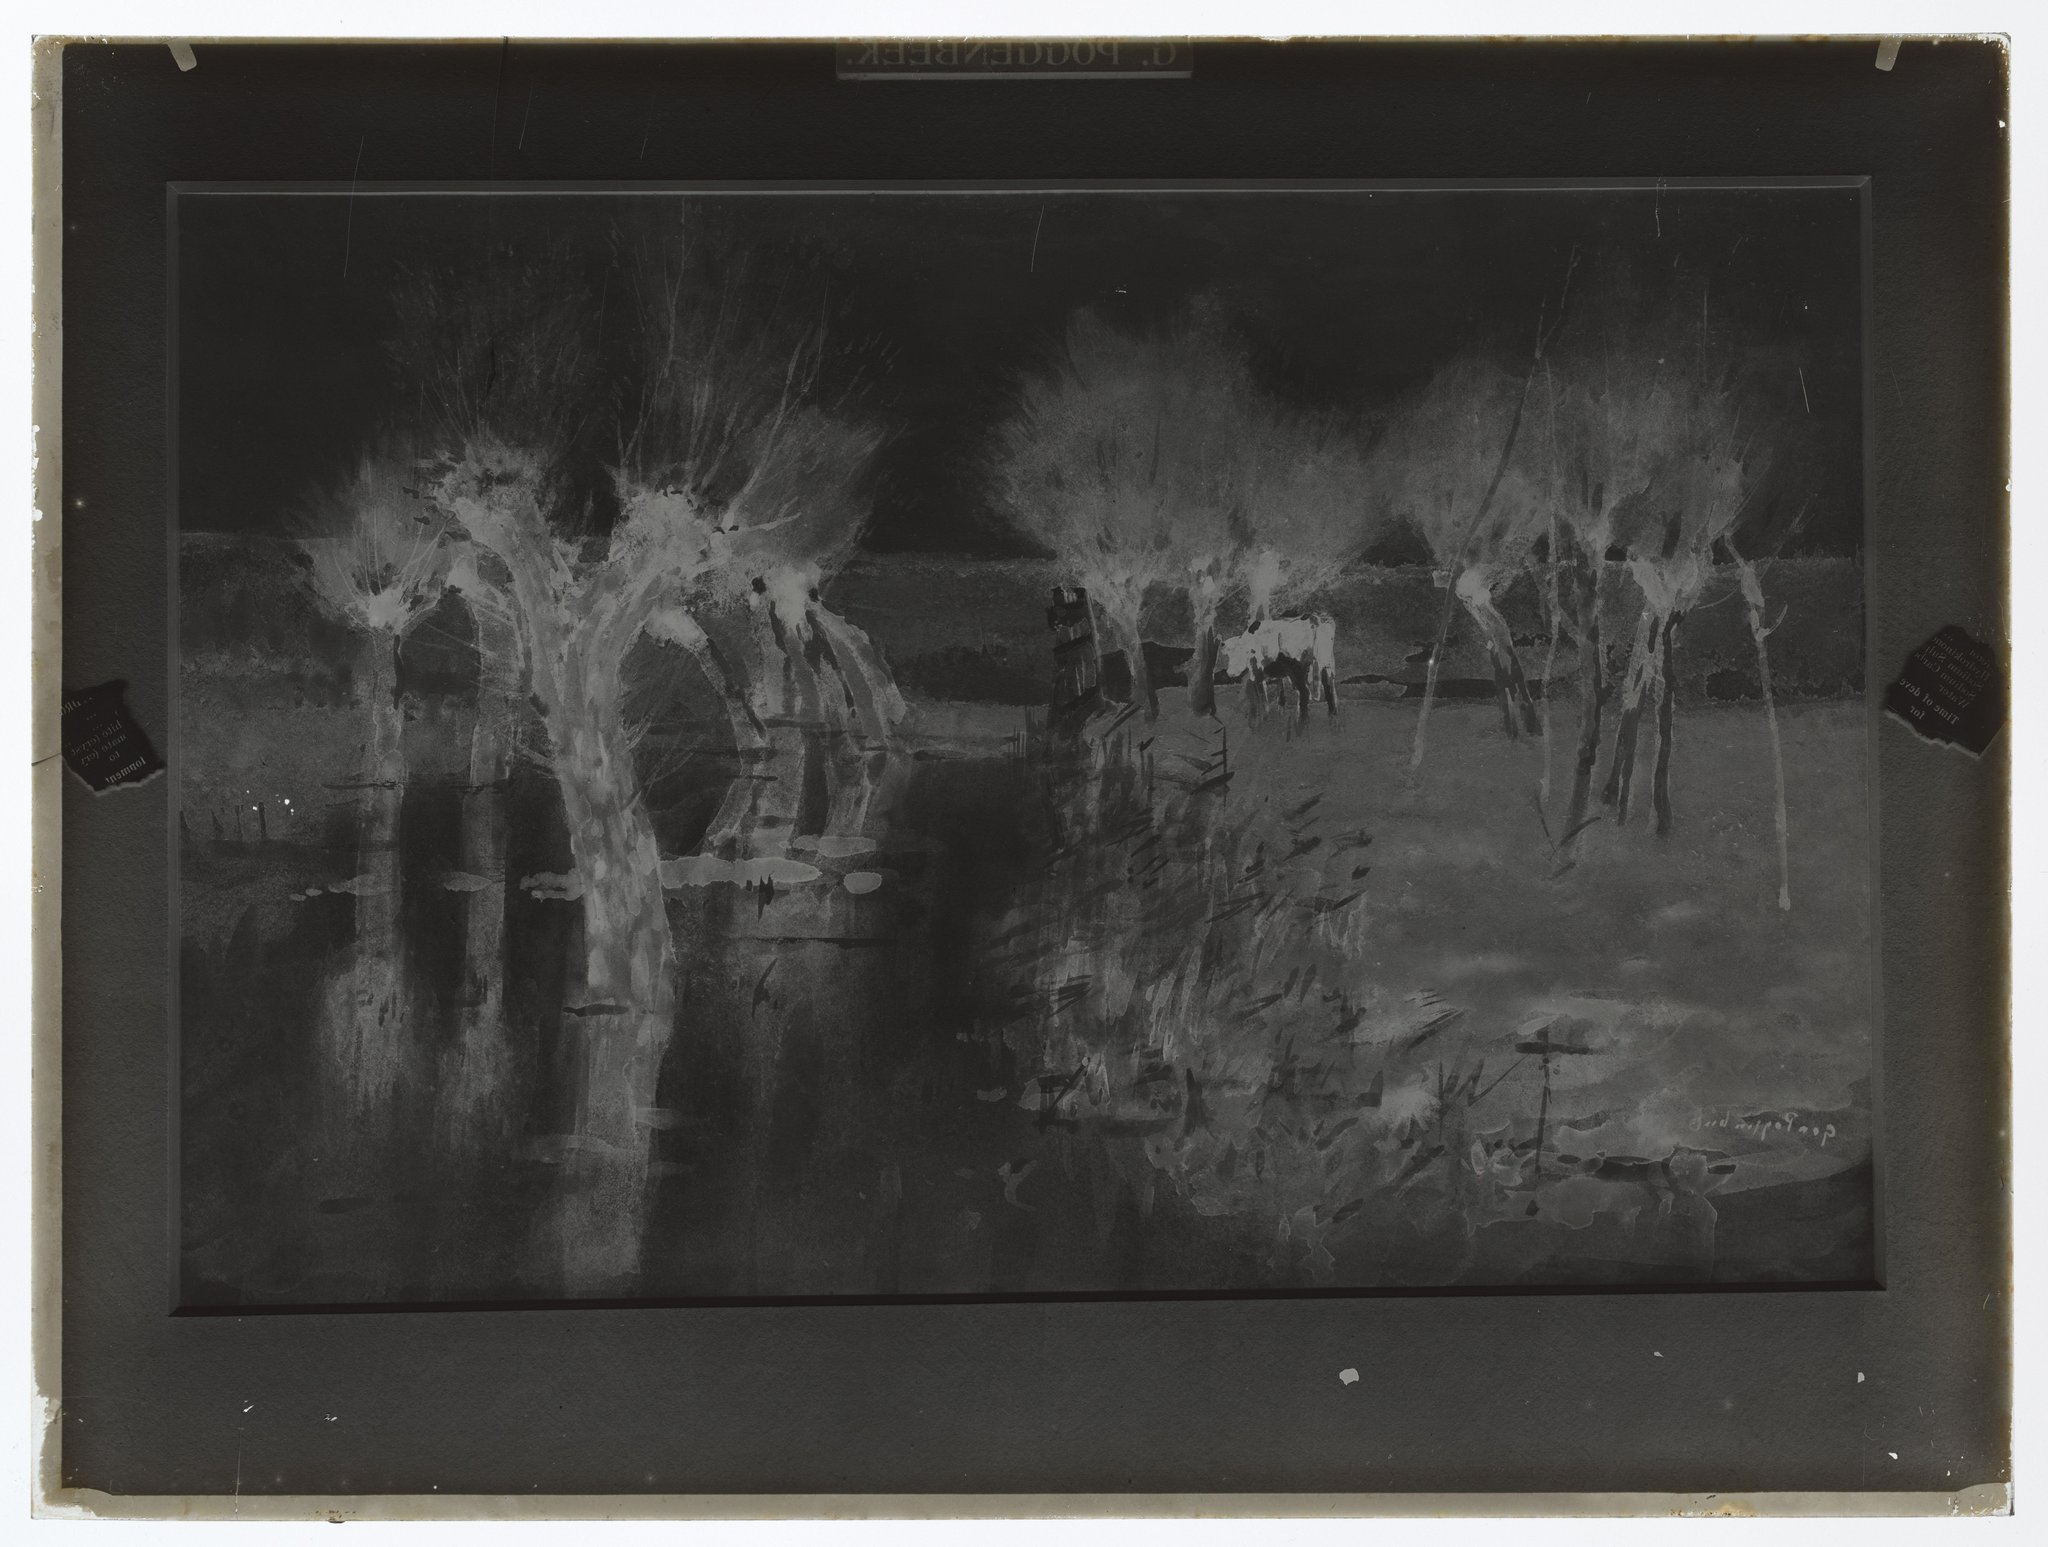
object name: reproduction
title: Fotoreproductie van de aquarel Hoog water in het weiland door Geo Poggenbeek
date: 1910-1930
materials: glass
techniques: gelatin glass negative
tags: cow, meadow, pasture